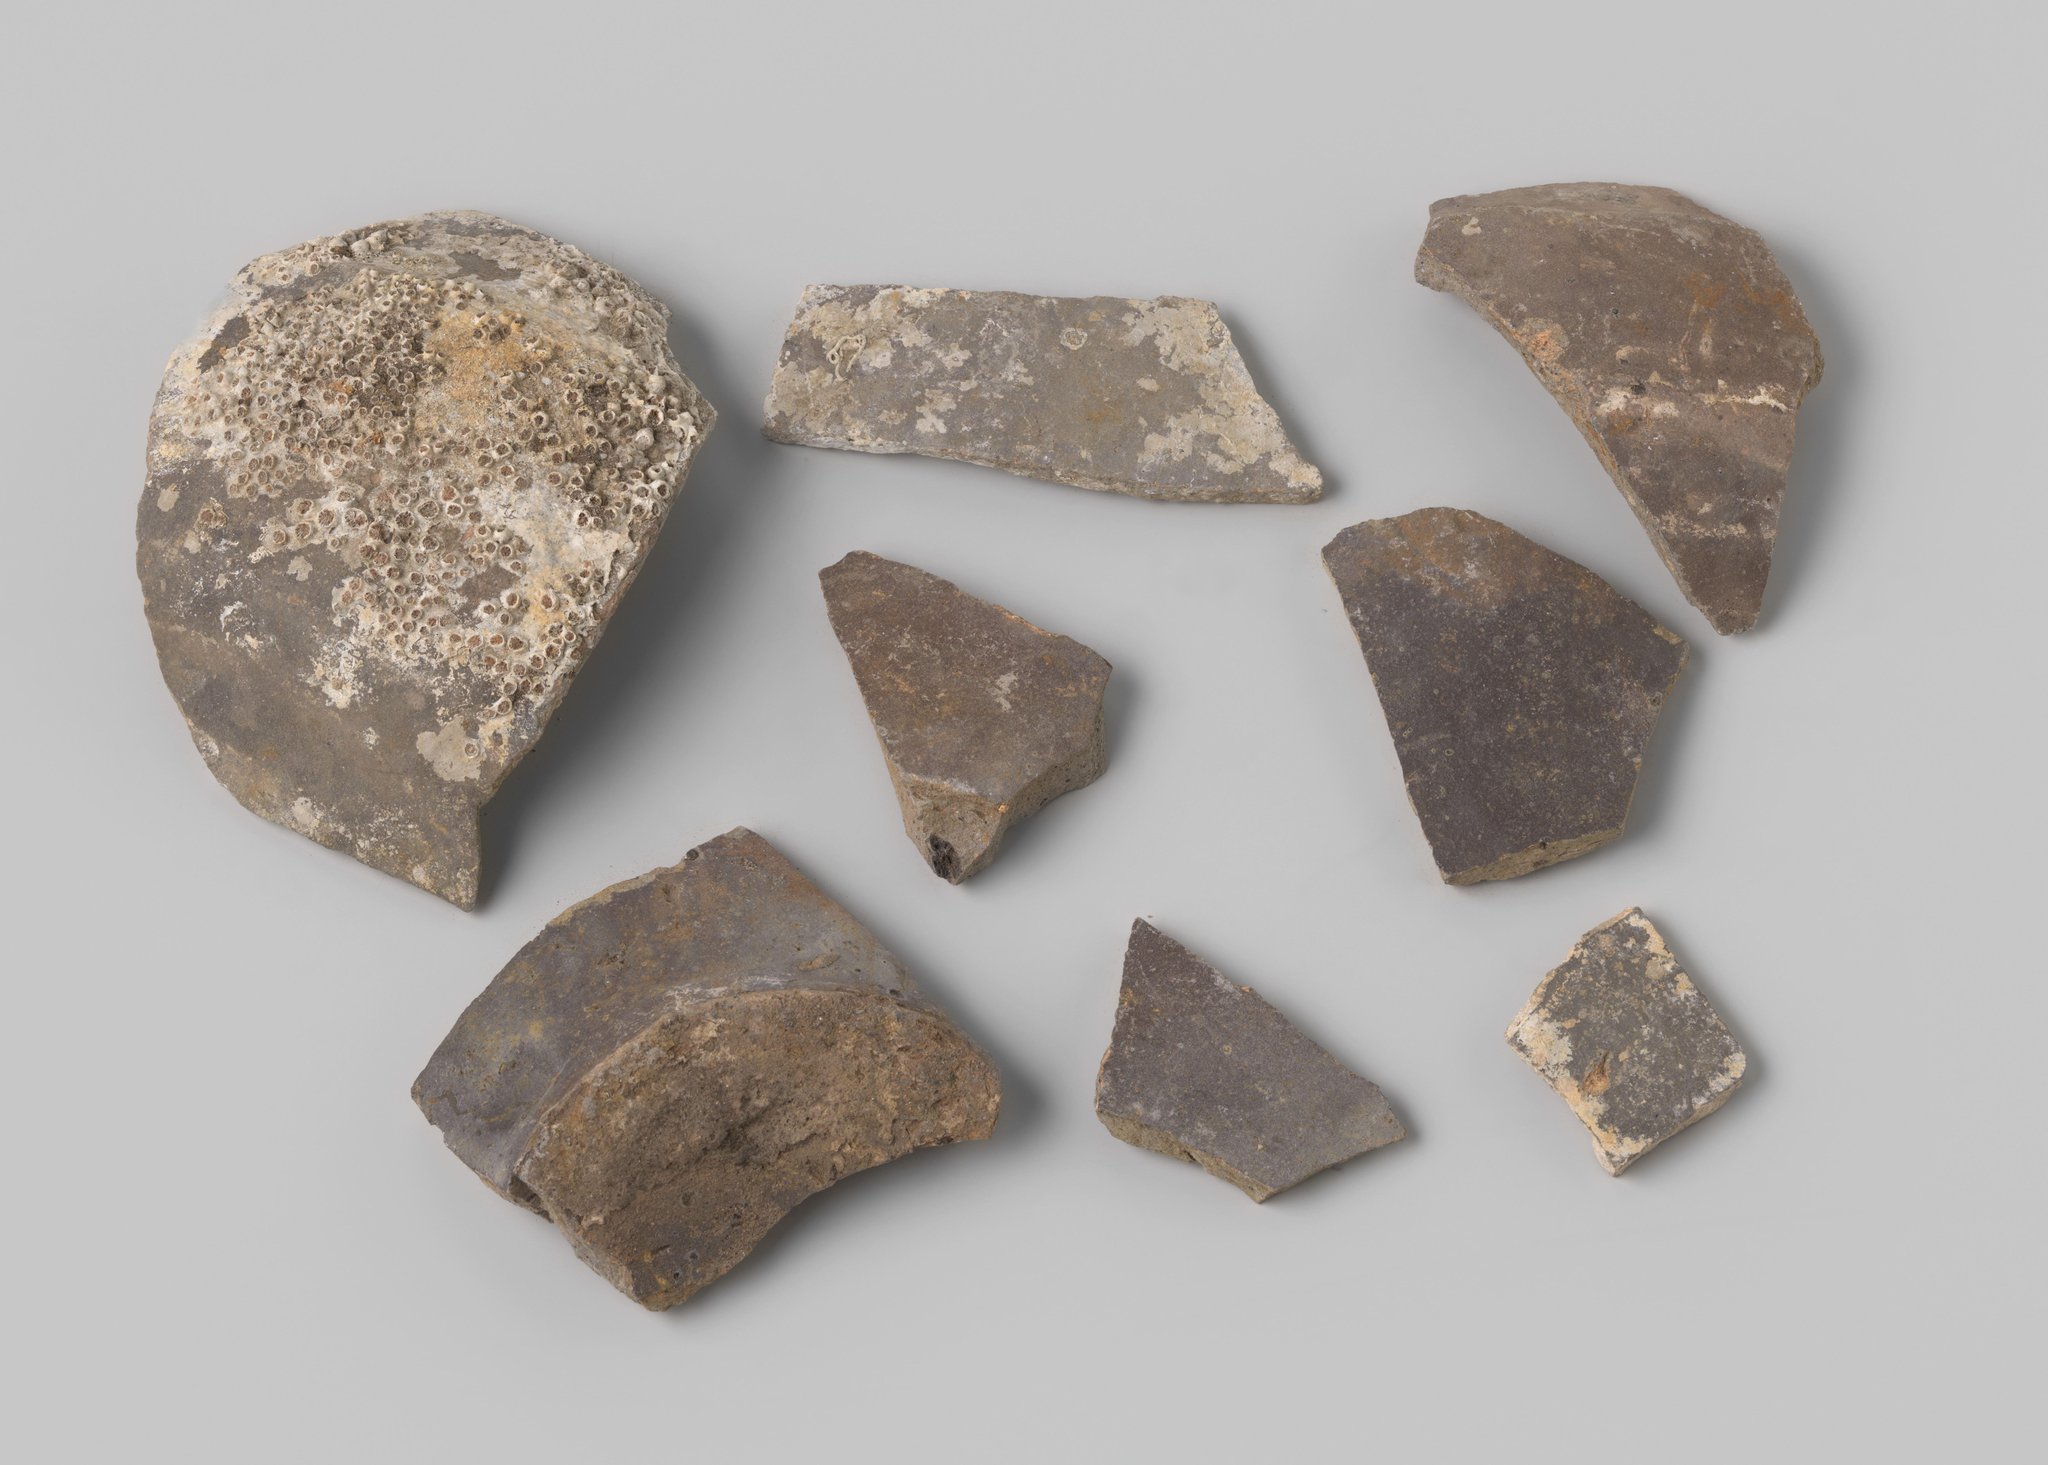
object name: martavaan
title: Scherven van martavanen uit V.O.C.-schip de 'Witte Leeuw'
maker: Anonymous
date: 1613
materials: porcelain, stoneware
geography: southeast asia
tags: verenigde oostindische compagnie, sint-helena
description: Scherven van martavanen uit V.O.C.-schip de 'Witte Leeuw'.